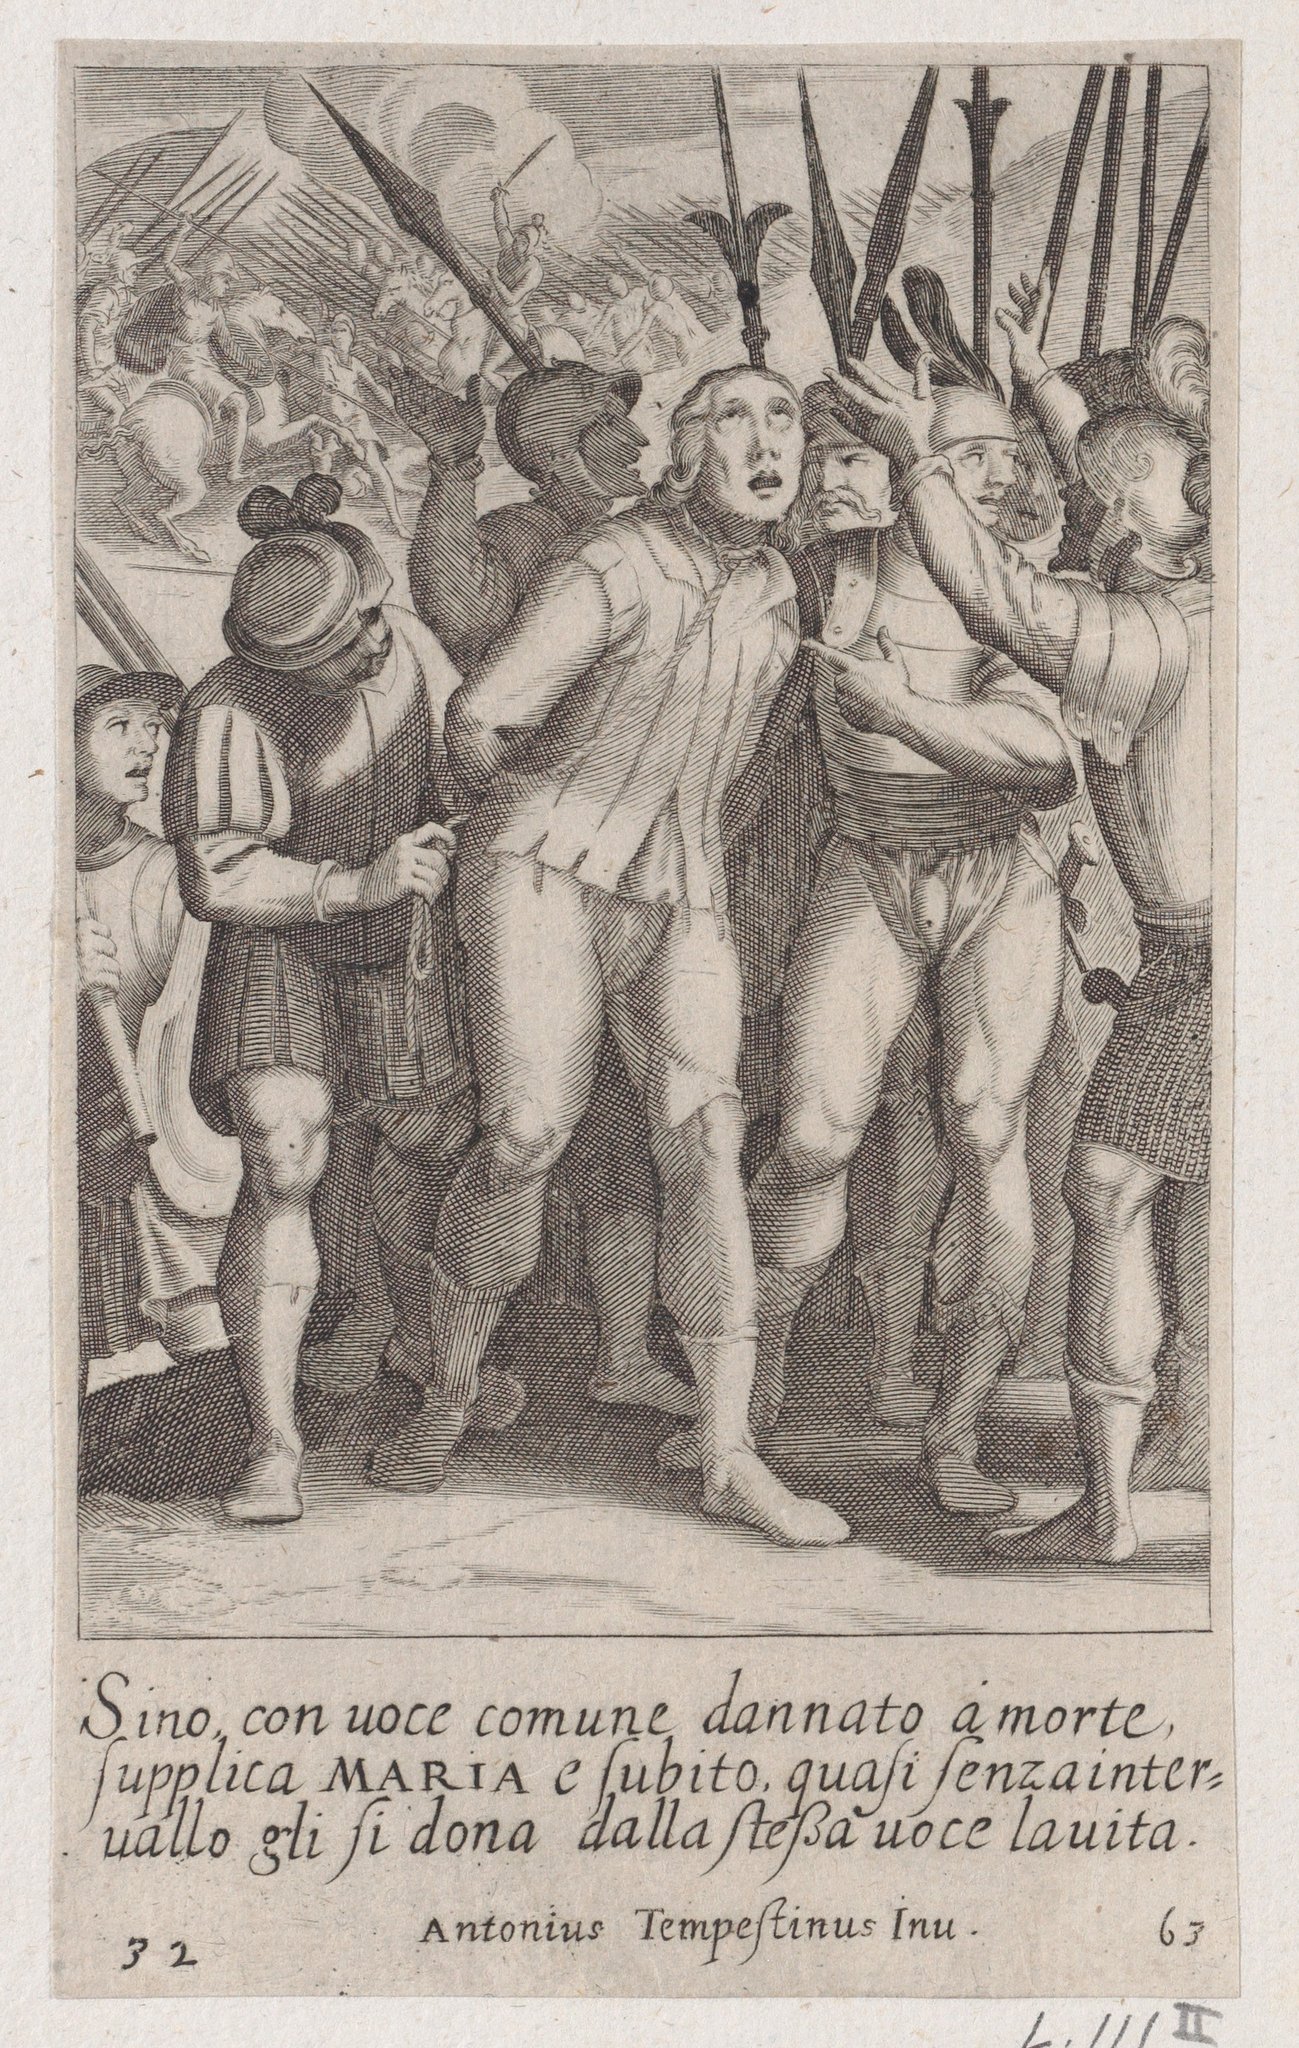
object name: print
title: Sino, from Scelta d'Alcuni Miracoli e Grazie della Santissima Nunziata di Firenze (Selection of Some Miracles and Graces that Occurred in the Church of the Annunziata in Florence)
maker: jacques callot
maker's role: artist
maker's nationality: french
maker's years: 1592-1635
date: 1611-1619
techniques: engraving